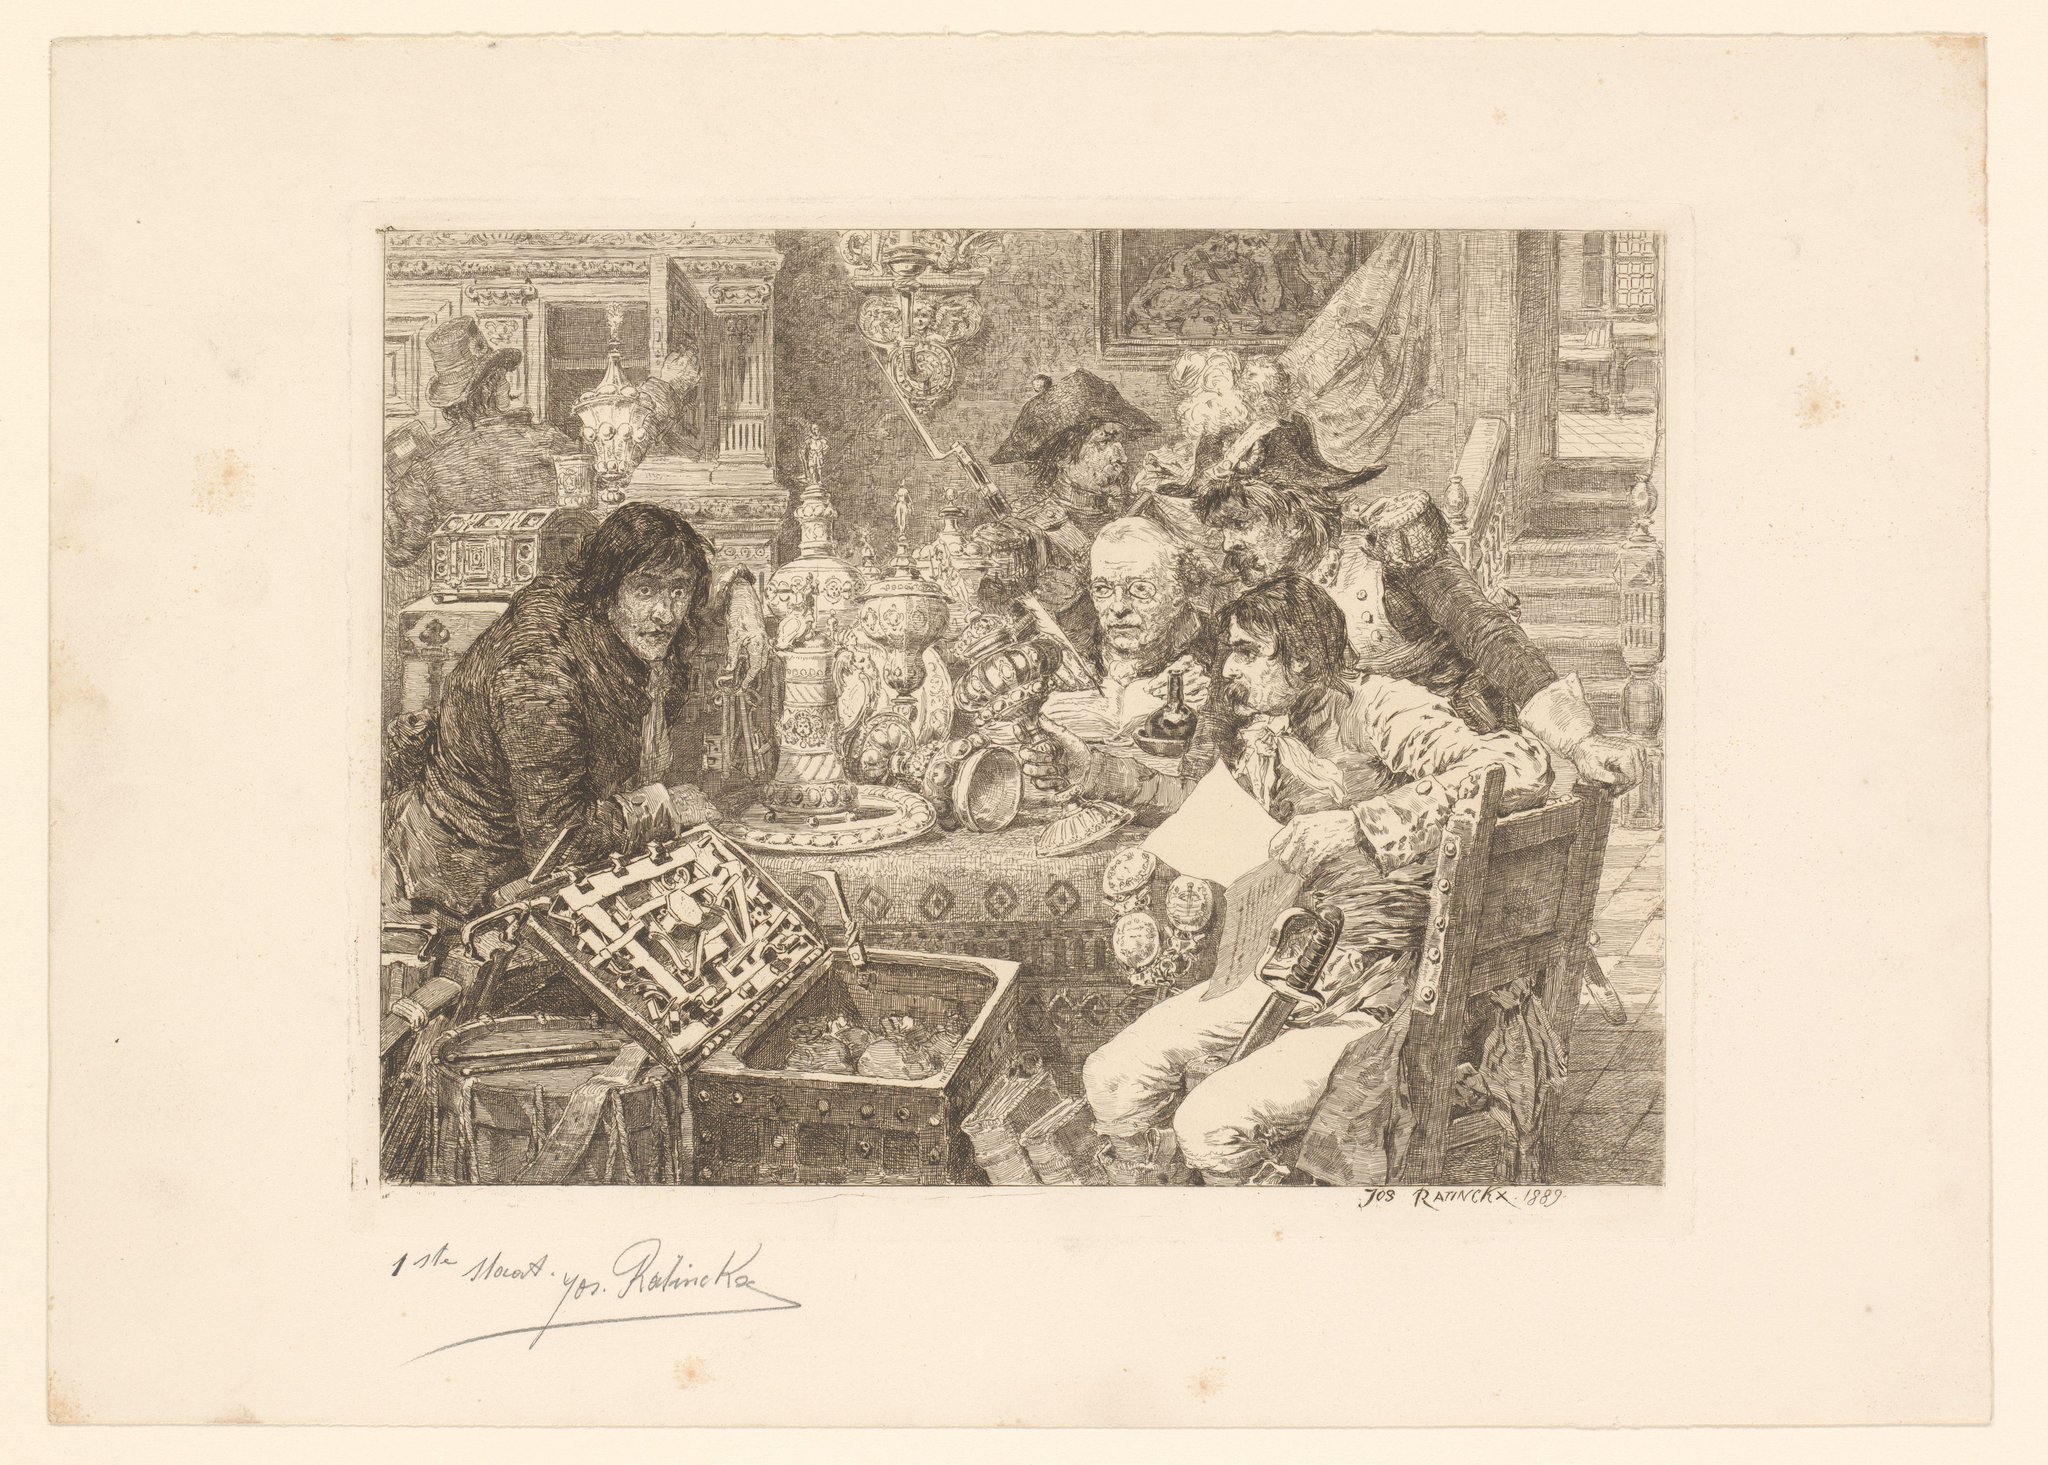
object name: print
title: Zes mannen in een interieur rondom een tafel bekijken rijkelijk vaatwerk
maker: jos ratinckx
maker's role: print maker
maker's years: 1860-1937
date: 1889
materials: paper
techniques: etching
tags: mug, beaker, goblet, interior ~ representation of a building, money-chest, treasure-chest, money-box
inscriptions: collector's mark: Lugt 2228, inscription: ‘1ste staat’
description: De prent verwijst naar de vernietiging van de gildeschatten in 1794.